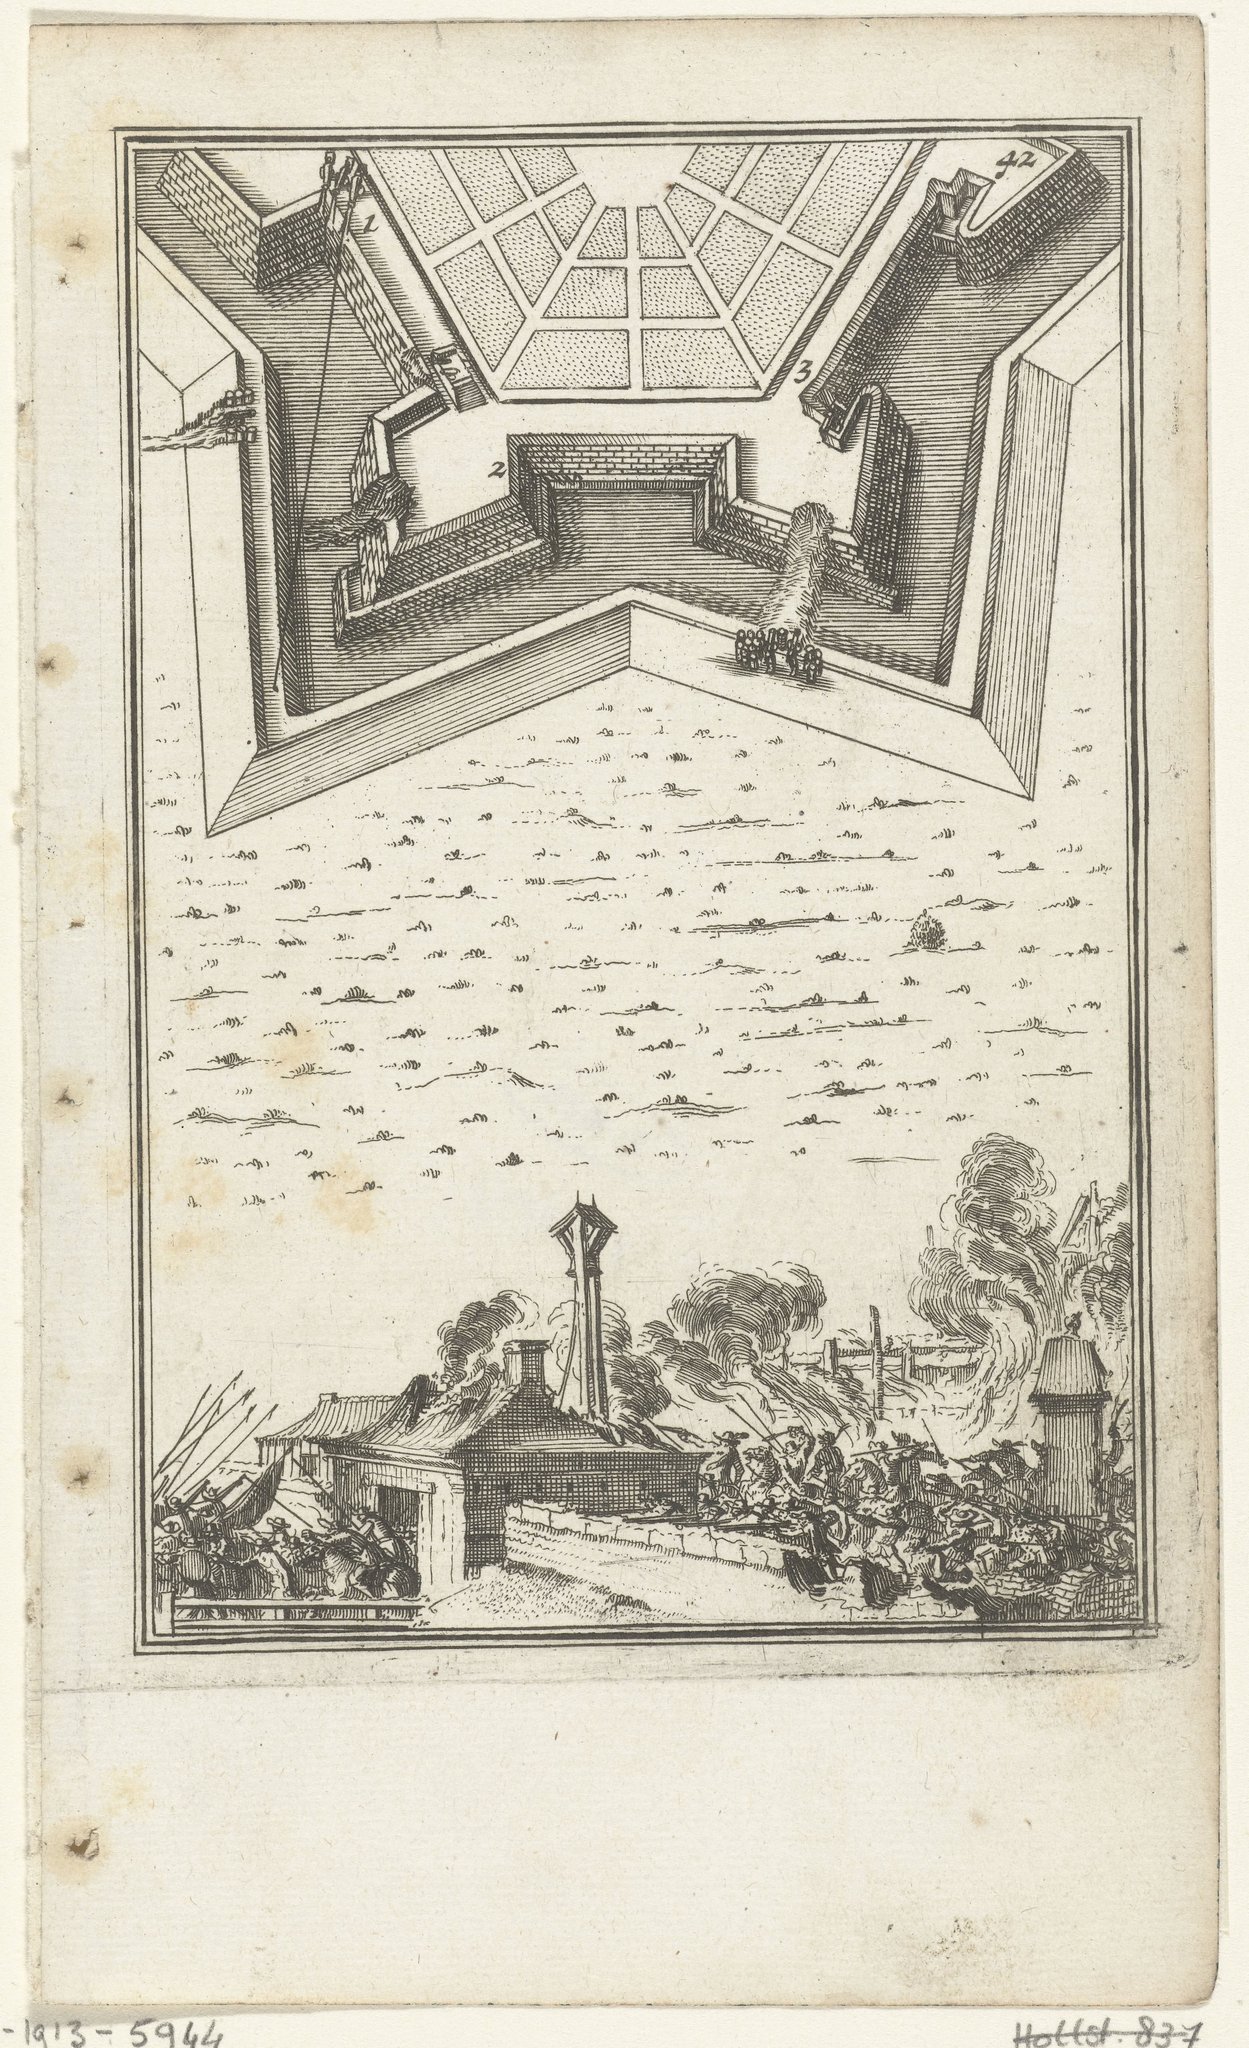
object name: print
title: Illustratie voor 'Den Arbeid van Mars' van Allain Manesson Mallet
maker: romeyn de hooghe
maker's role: draughtsman, goldsmith, painter, print maker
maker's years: 1645-1708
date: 1672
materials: paper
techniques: etching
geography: amsterdam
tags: battle, fortifications, military engineering, putting the enemy to flight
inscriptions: collector's mark: Lugt 2228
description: Plattegrond van een deel van een vesting, fort of versterking. Daaronder worden soldaten een stad of vesting uit gejaagd. In de hoek rechtsboven het cijfer 42 (= het nummer van de pagina in het boek waartegenover de illustratie geplaatst is).